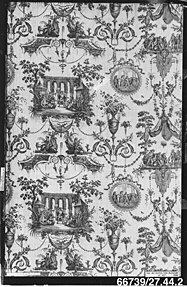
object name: furnishing textile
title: "Marriage of Figaro"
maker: jean-baptiste huet i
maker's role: designer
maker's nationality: french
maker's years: 1745-1811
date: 1785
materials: linen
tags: human figures,flowers